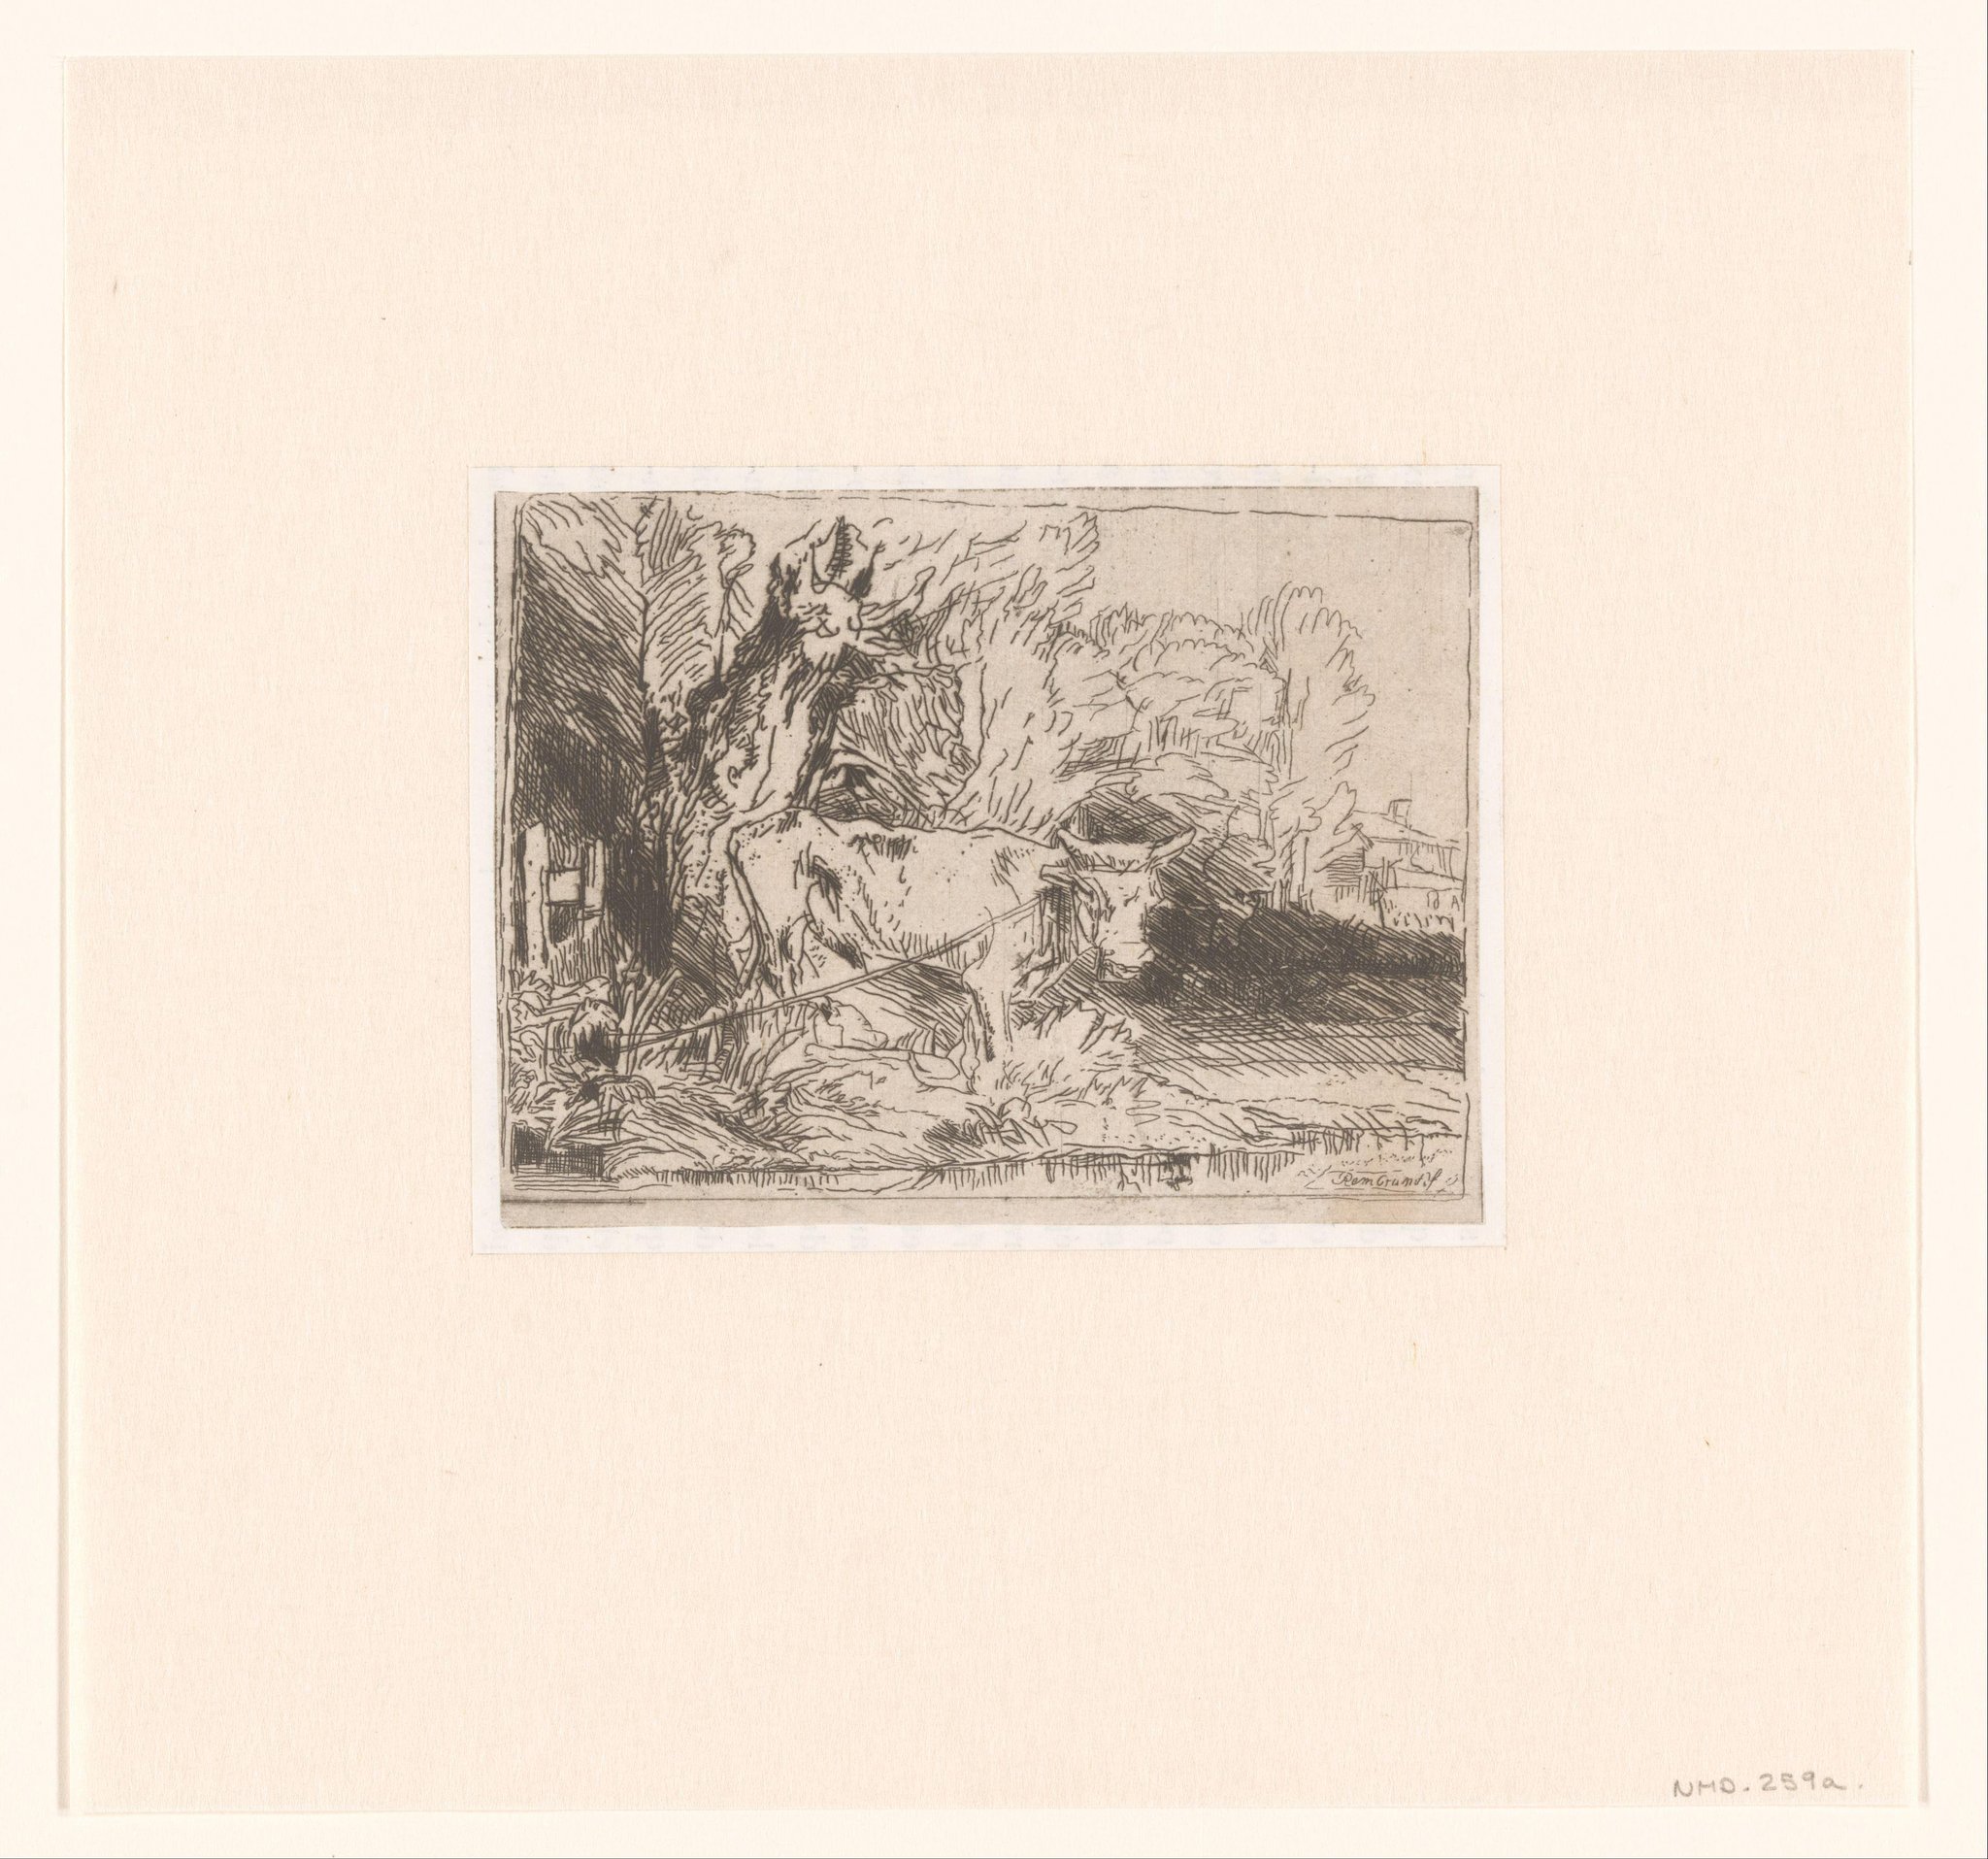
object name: print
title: The bull ('Het stiertje')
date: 1859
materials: paper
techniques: etching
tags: bull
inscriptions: collector's mark: Lugt 2760, collector's mark: Lugt 2228